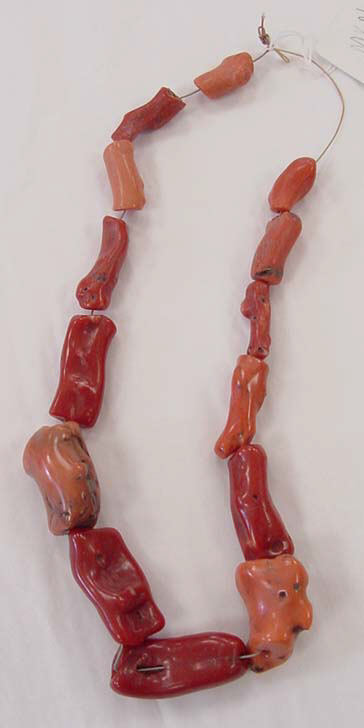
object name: necklace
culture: italian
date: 1801-1900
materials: coral